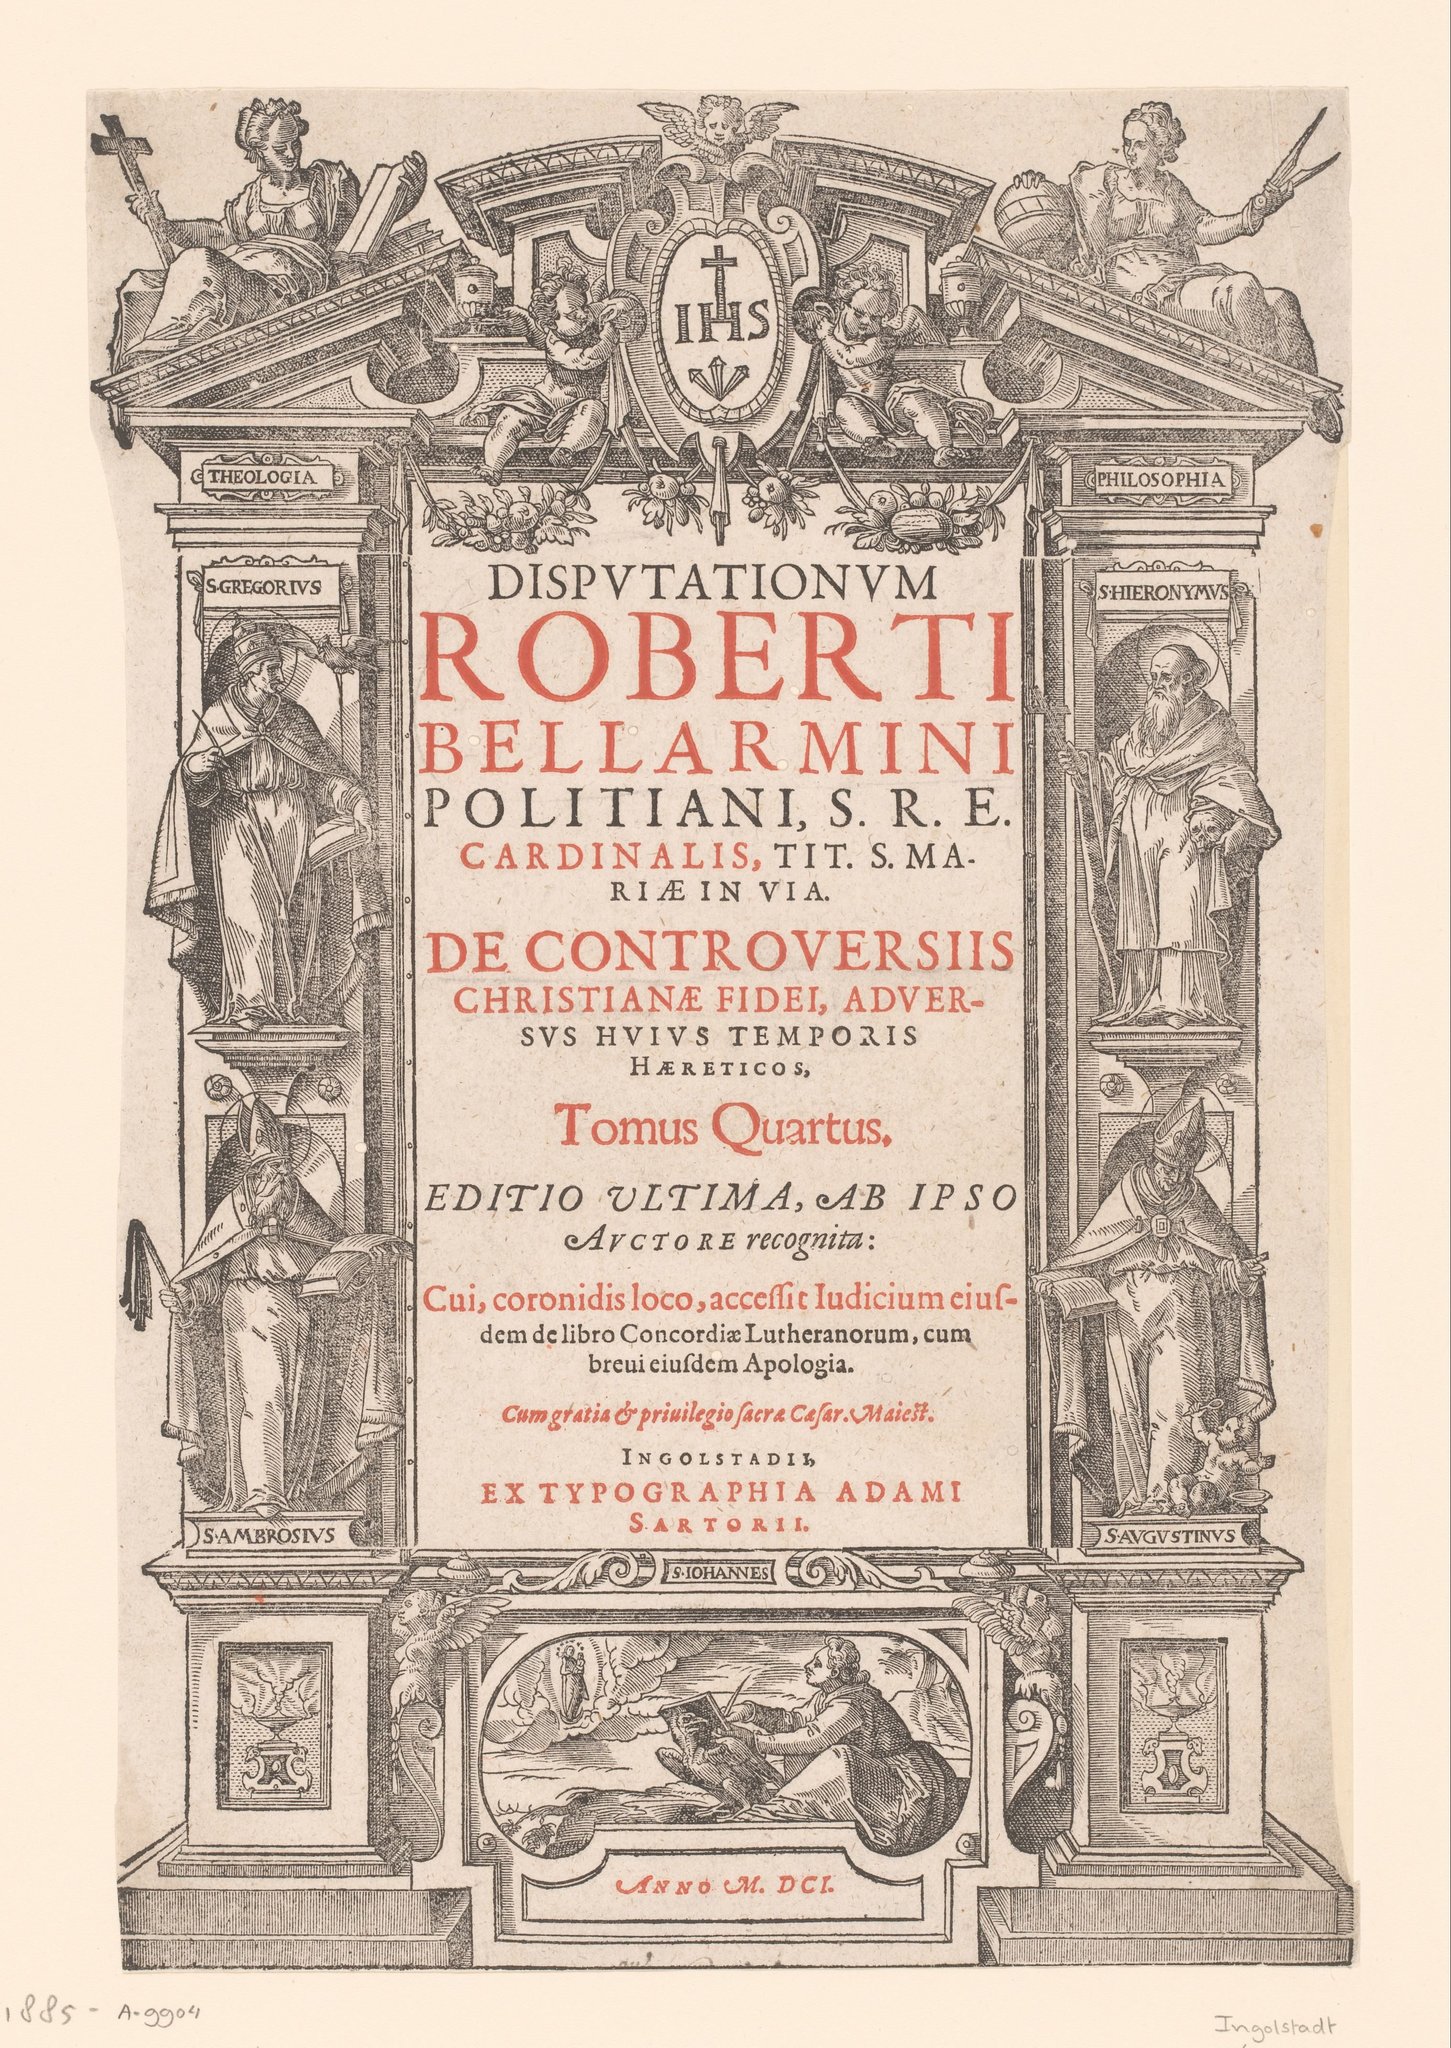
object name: print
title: Architectonische omlijsting met kerkvaders en Johannes de Evangelist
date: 1601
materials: paper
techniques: letterpress printing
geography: ingolstadt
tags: title-page, ornament derived from architectural details, doctors (fathers) of the church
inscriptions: collector's mark: Lugt 2228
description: Titelpagina voor: Bellarmino, Roberto. Disputationum Roberti Bellarmini Politiani (...). Ingolstadt: Adam Sartoris, 1601.